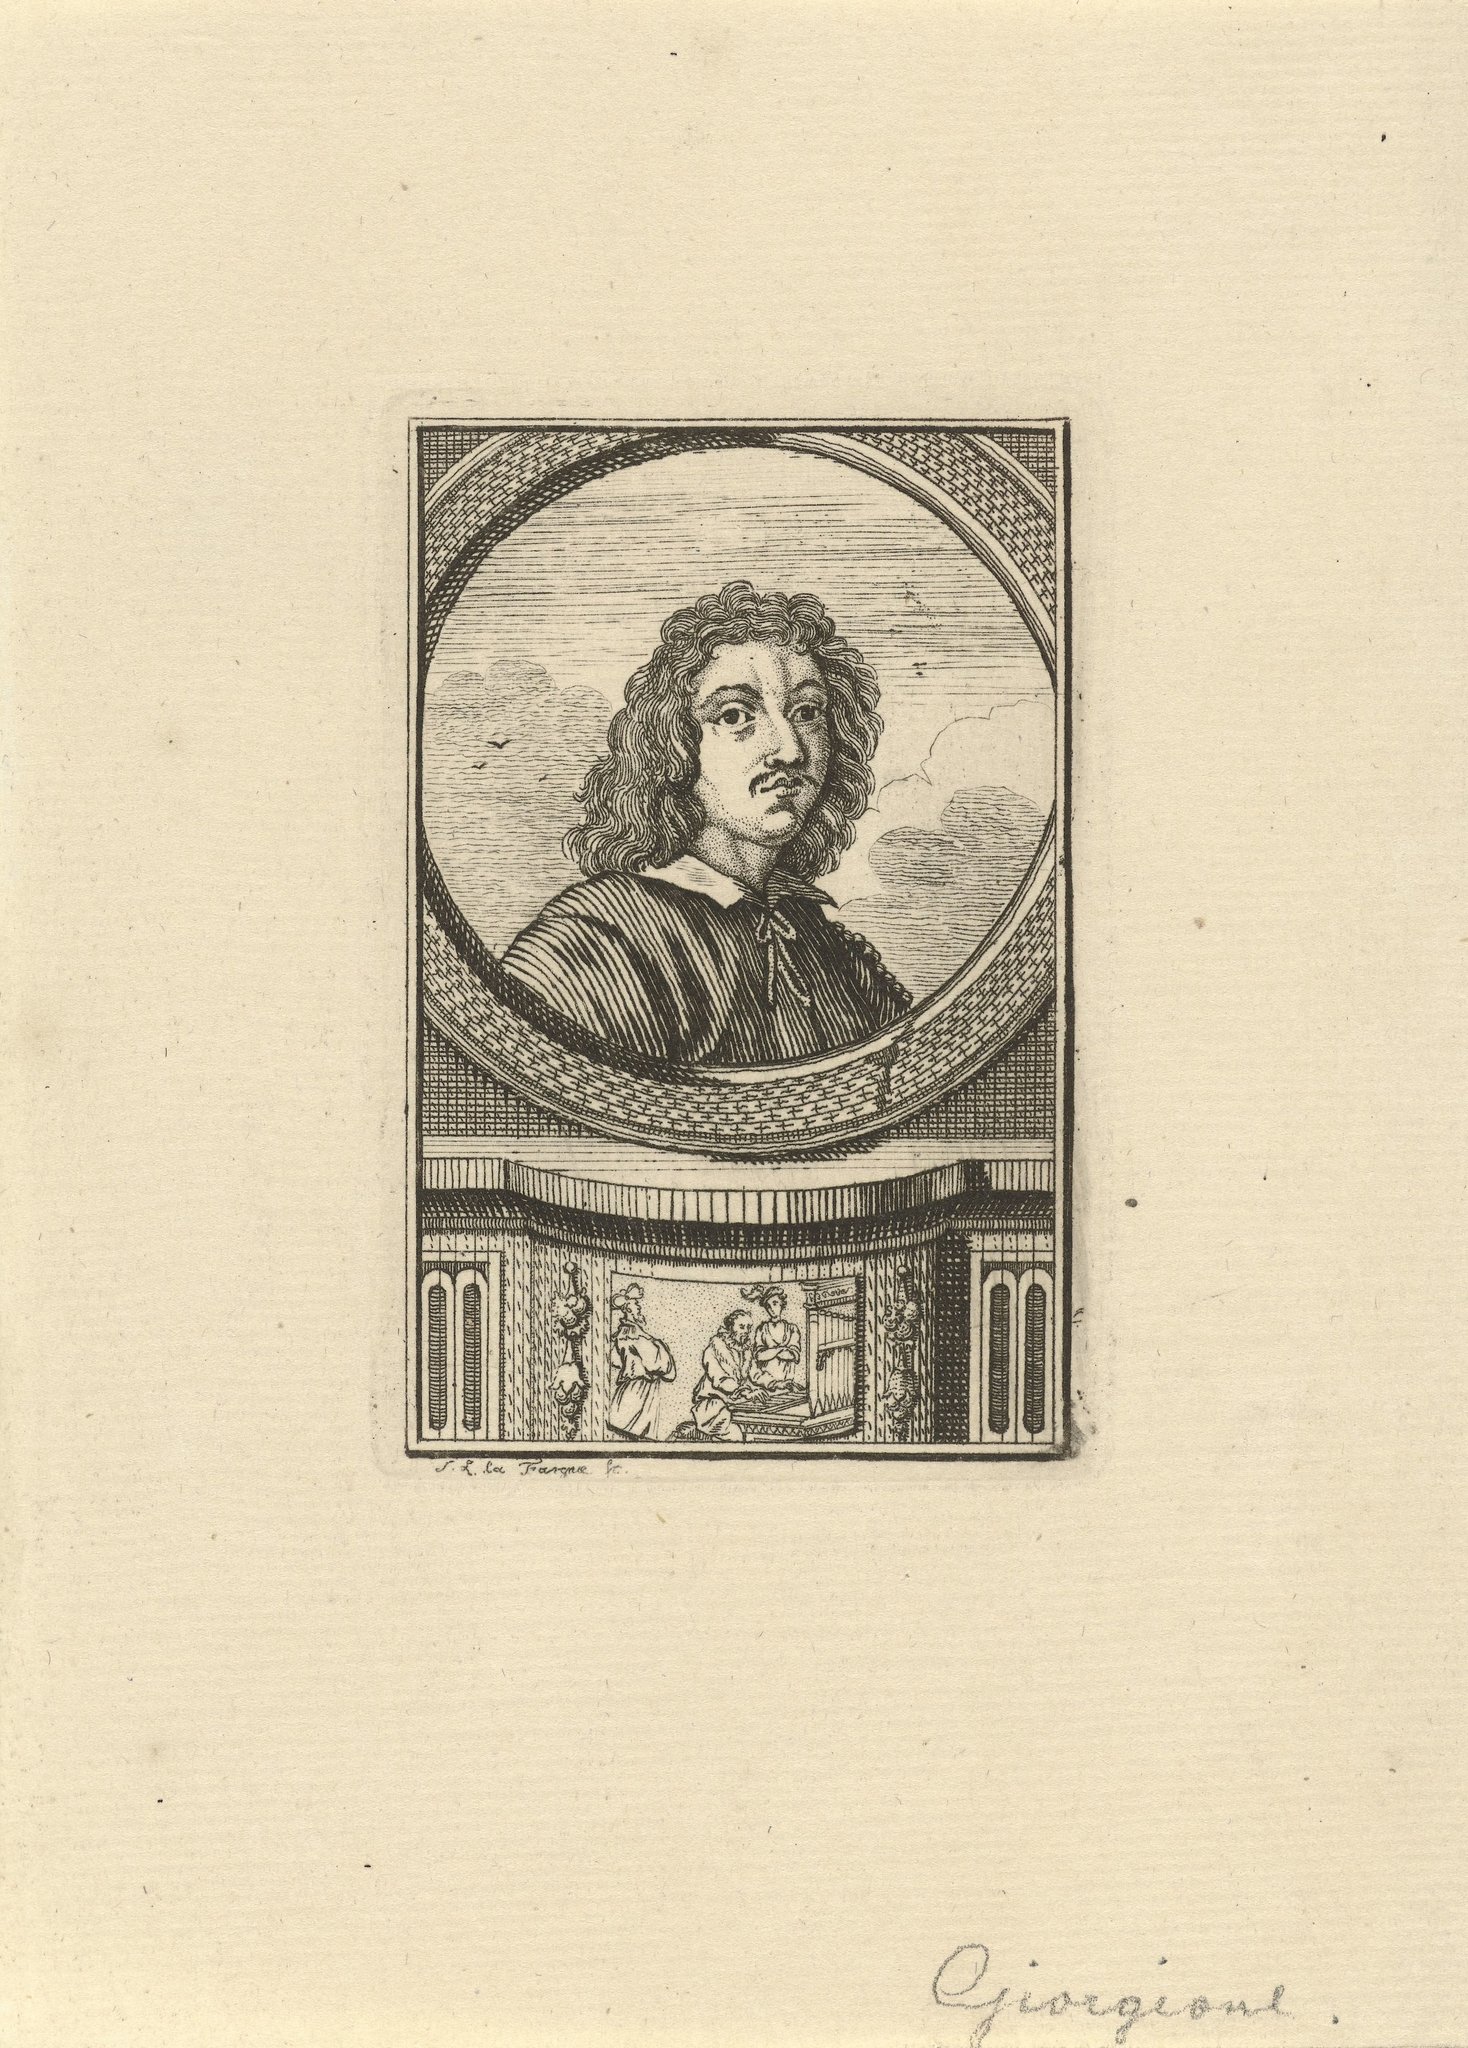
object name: print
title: Portret van Giorgione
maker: isaac lodewijk la fargue van nieuwland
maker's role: draughtsman, painter, print maker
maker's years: 1726-1805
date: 1752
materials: paper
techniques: etching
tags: venice, painter, giorgione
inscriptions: collector's mark: Lugt 2228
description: Prent opgenomen in: Dézallier d'Argenville, Antoine Joseph. Tooneel der uitmuntende schilders van Europa, en byzonderlyk van Nederland. Den Haag: Mattheus Gaillard, 1752.